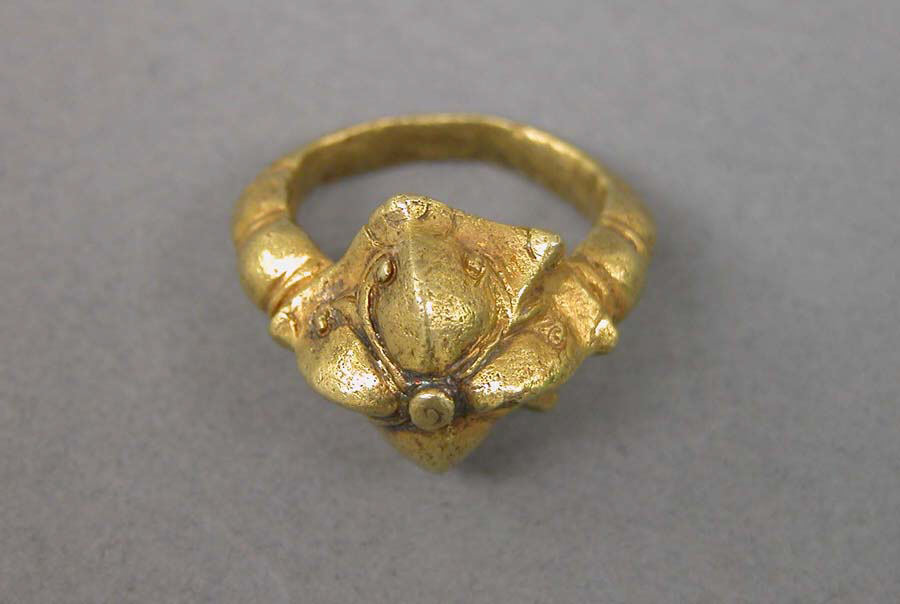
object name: ring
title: Ring with Domed Bezel of Foliate Shape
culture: indonesian, javanese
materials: gold